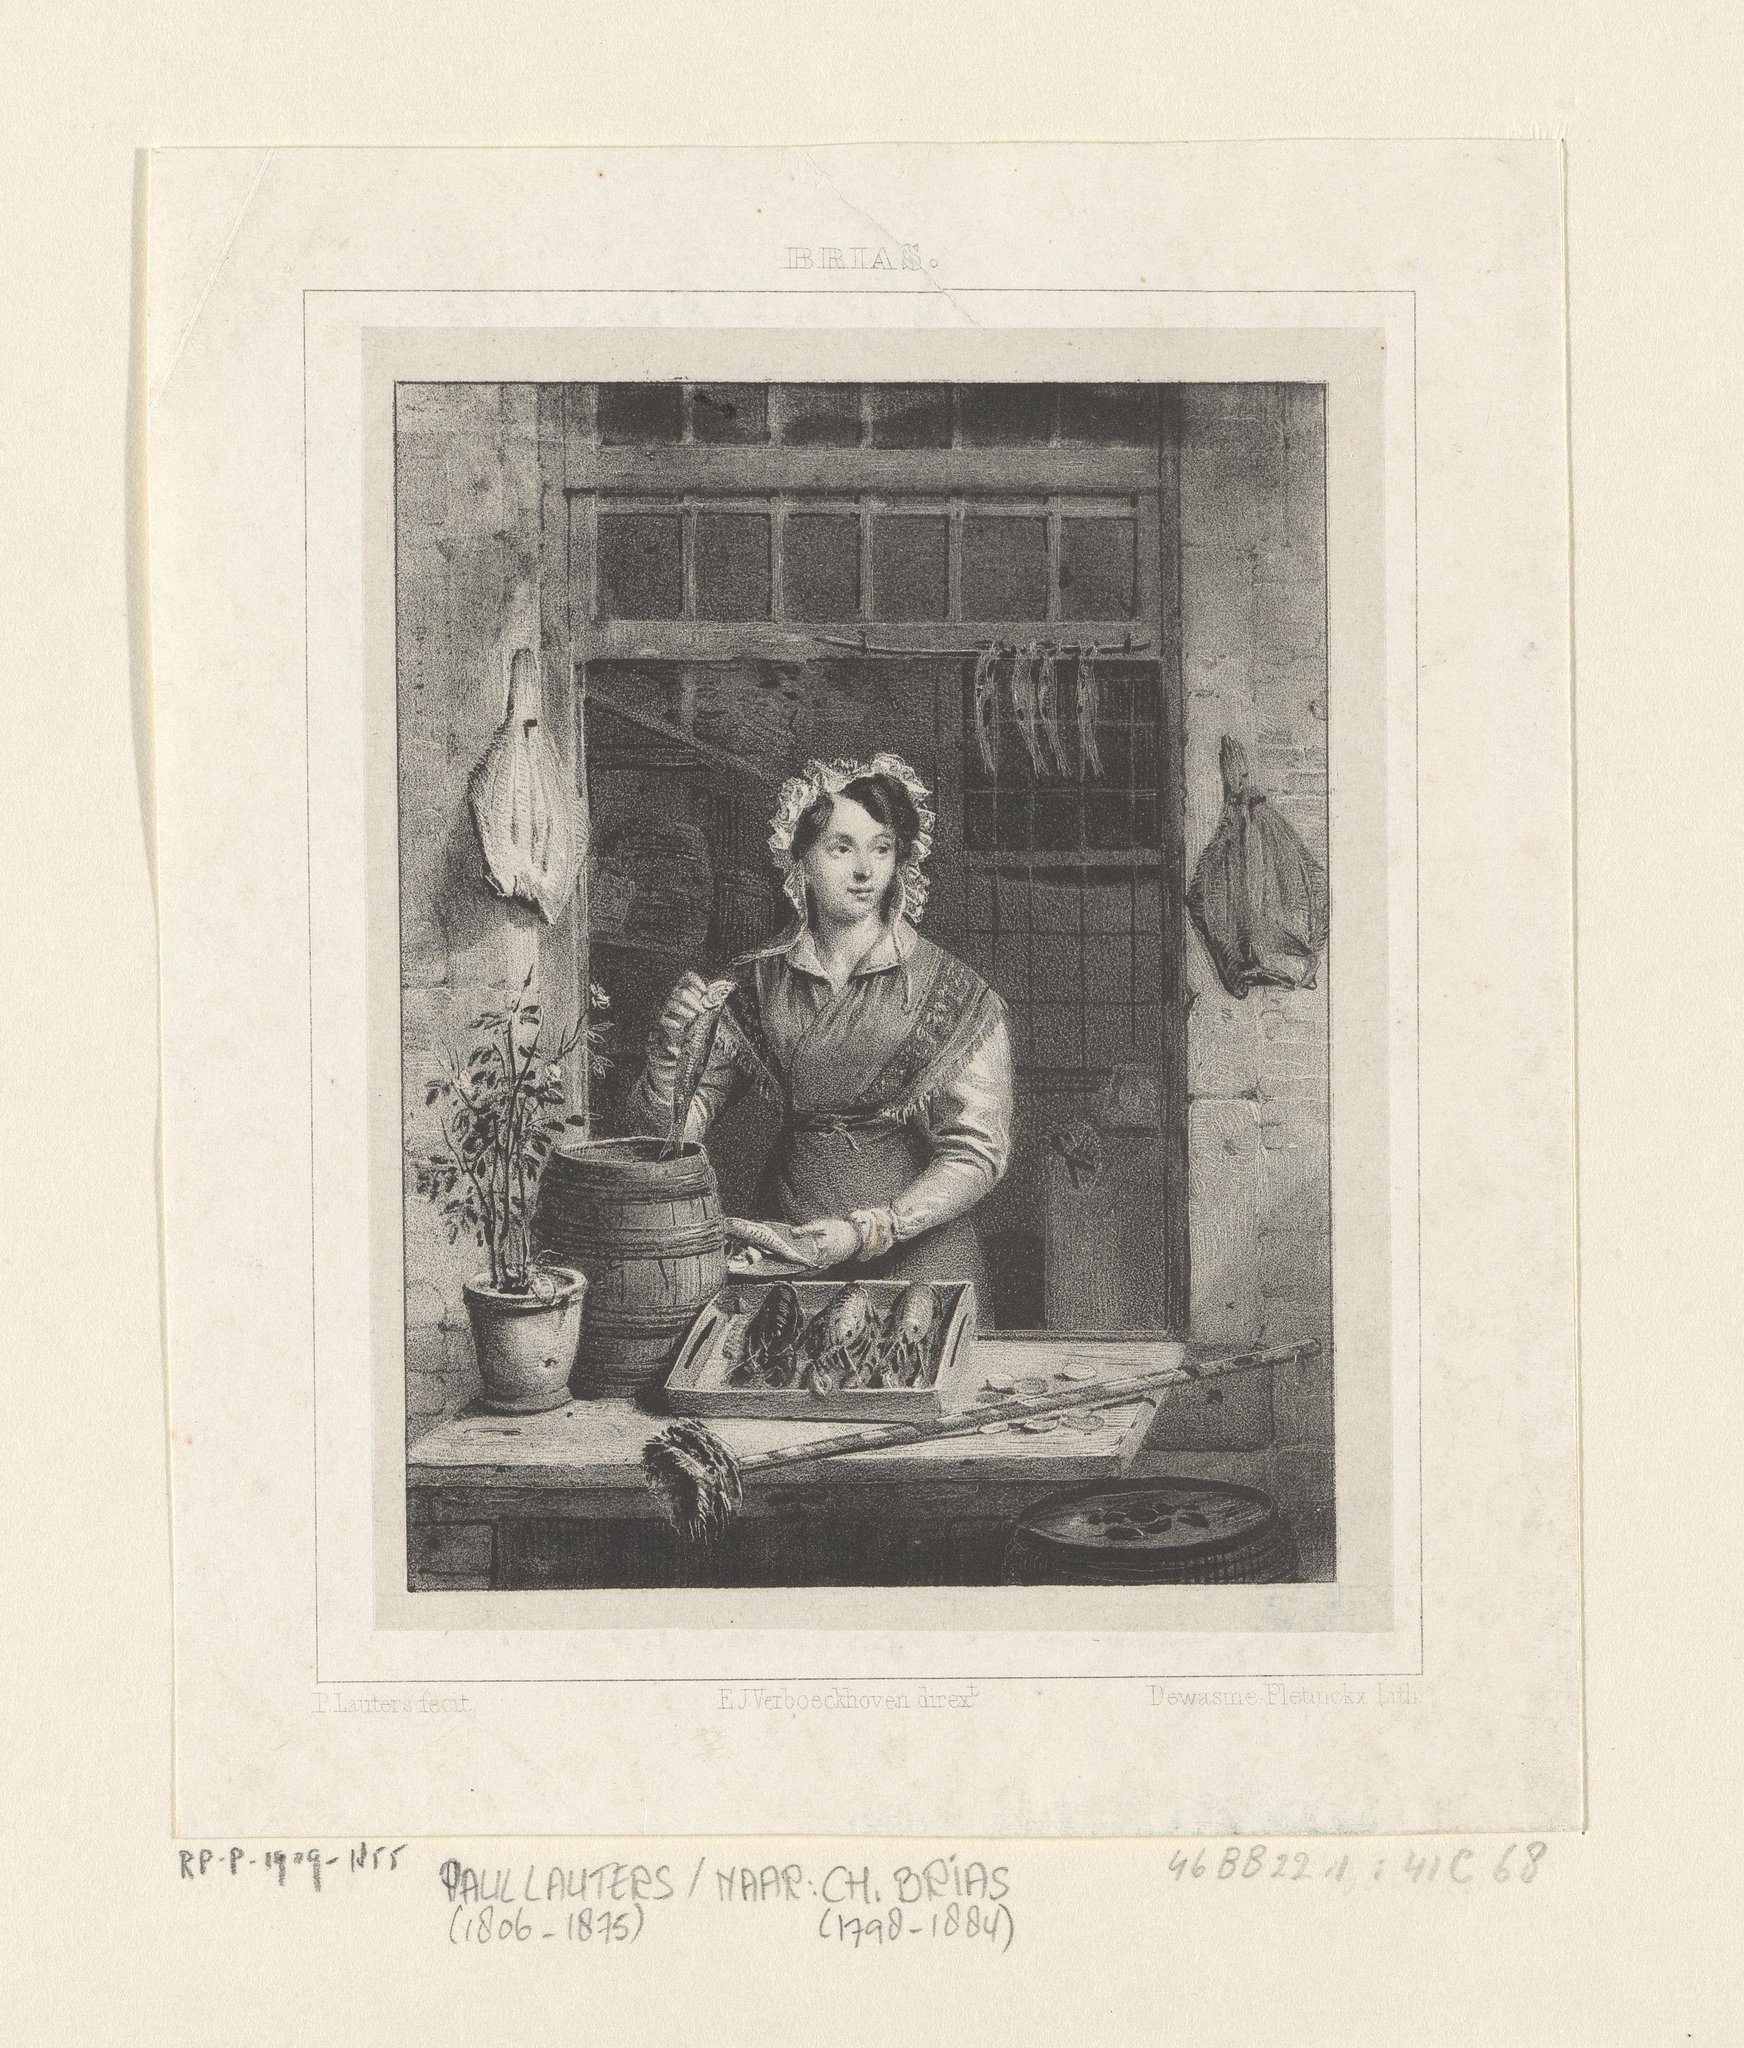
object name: print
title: Album lithographié par Paul Lauters d'après les dessins des principaux peintres du Royaume des Pays-Bas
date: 1829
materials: paper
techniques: lithograph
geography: brussels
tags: fishes, merchant, salesman - bb - women engaged in trade and commerce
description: Prent verschenen in: Verboeckhoven, Eugène. Album lithographié par Paul Lauters d'après les dessins des principaux peintres du Royaume des Pays-Bas. Brussel: Antoine Dewasme-Pletinckx, 1829.